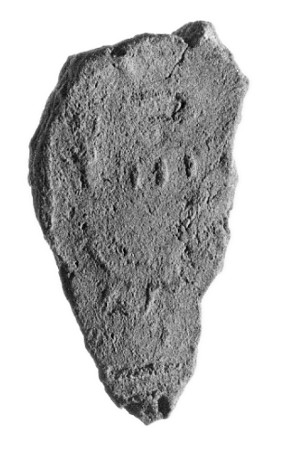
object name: sealing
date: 2030-1640 BCE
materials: clay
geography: egypt